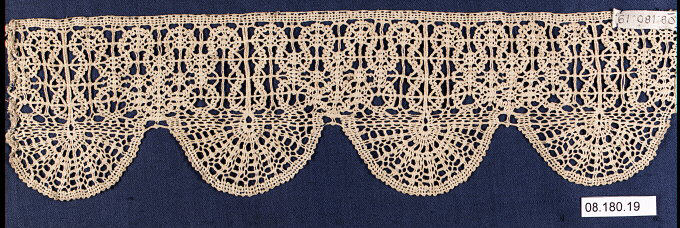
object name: strip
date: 1701-1800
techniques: lace